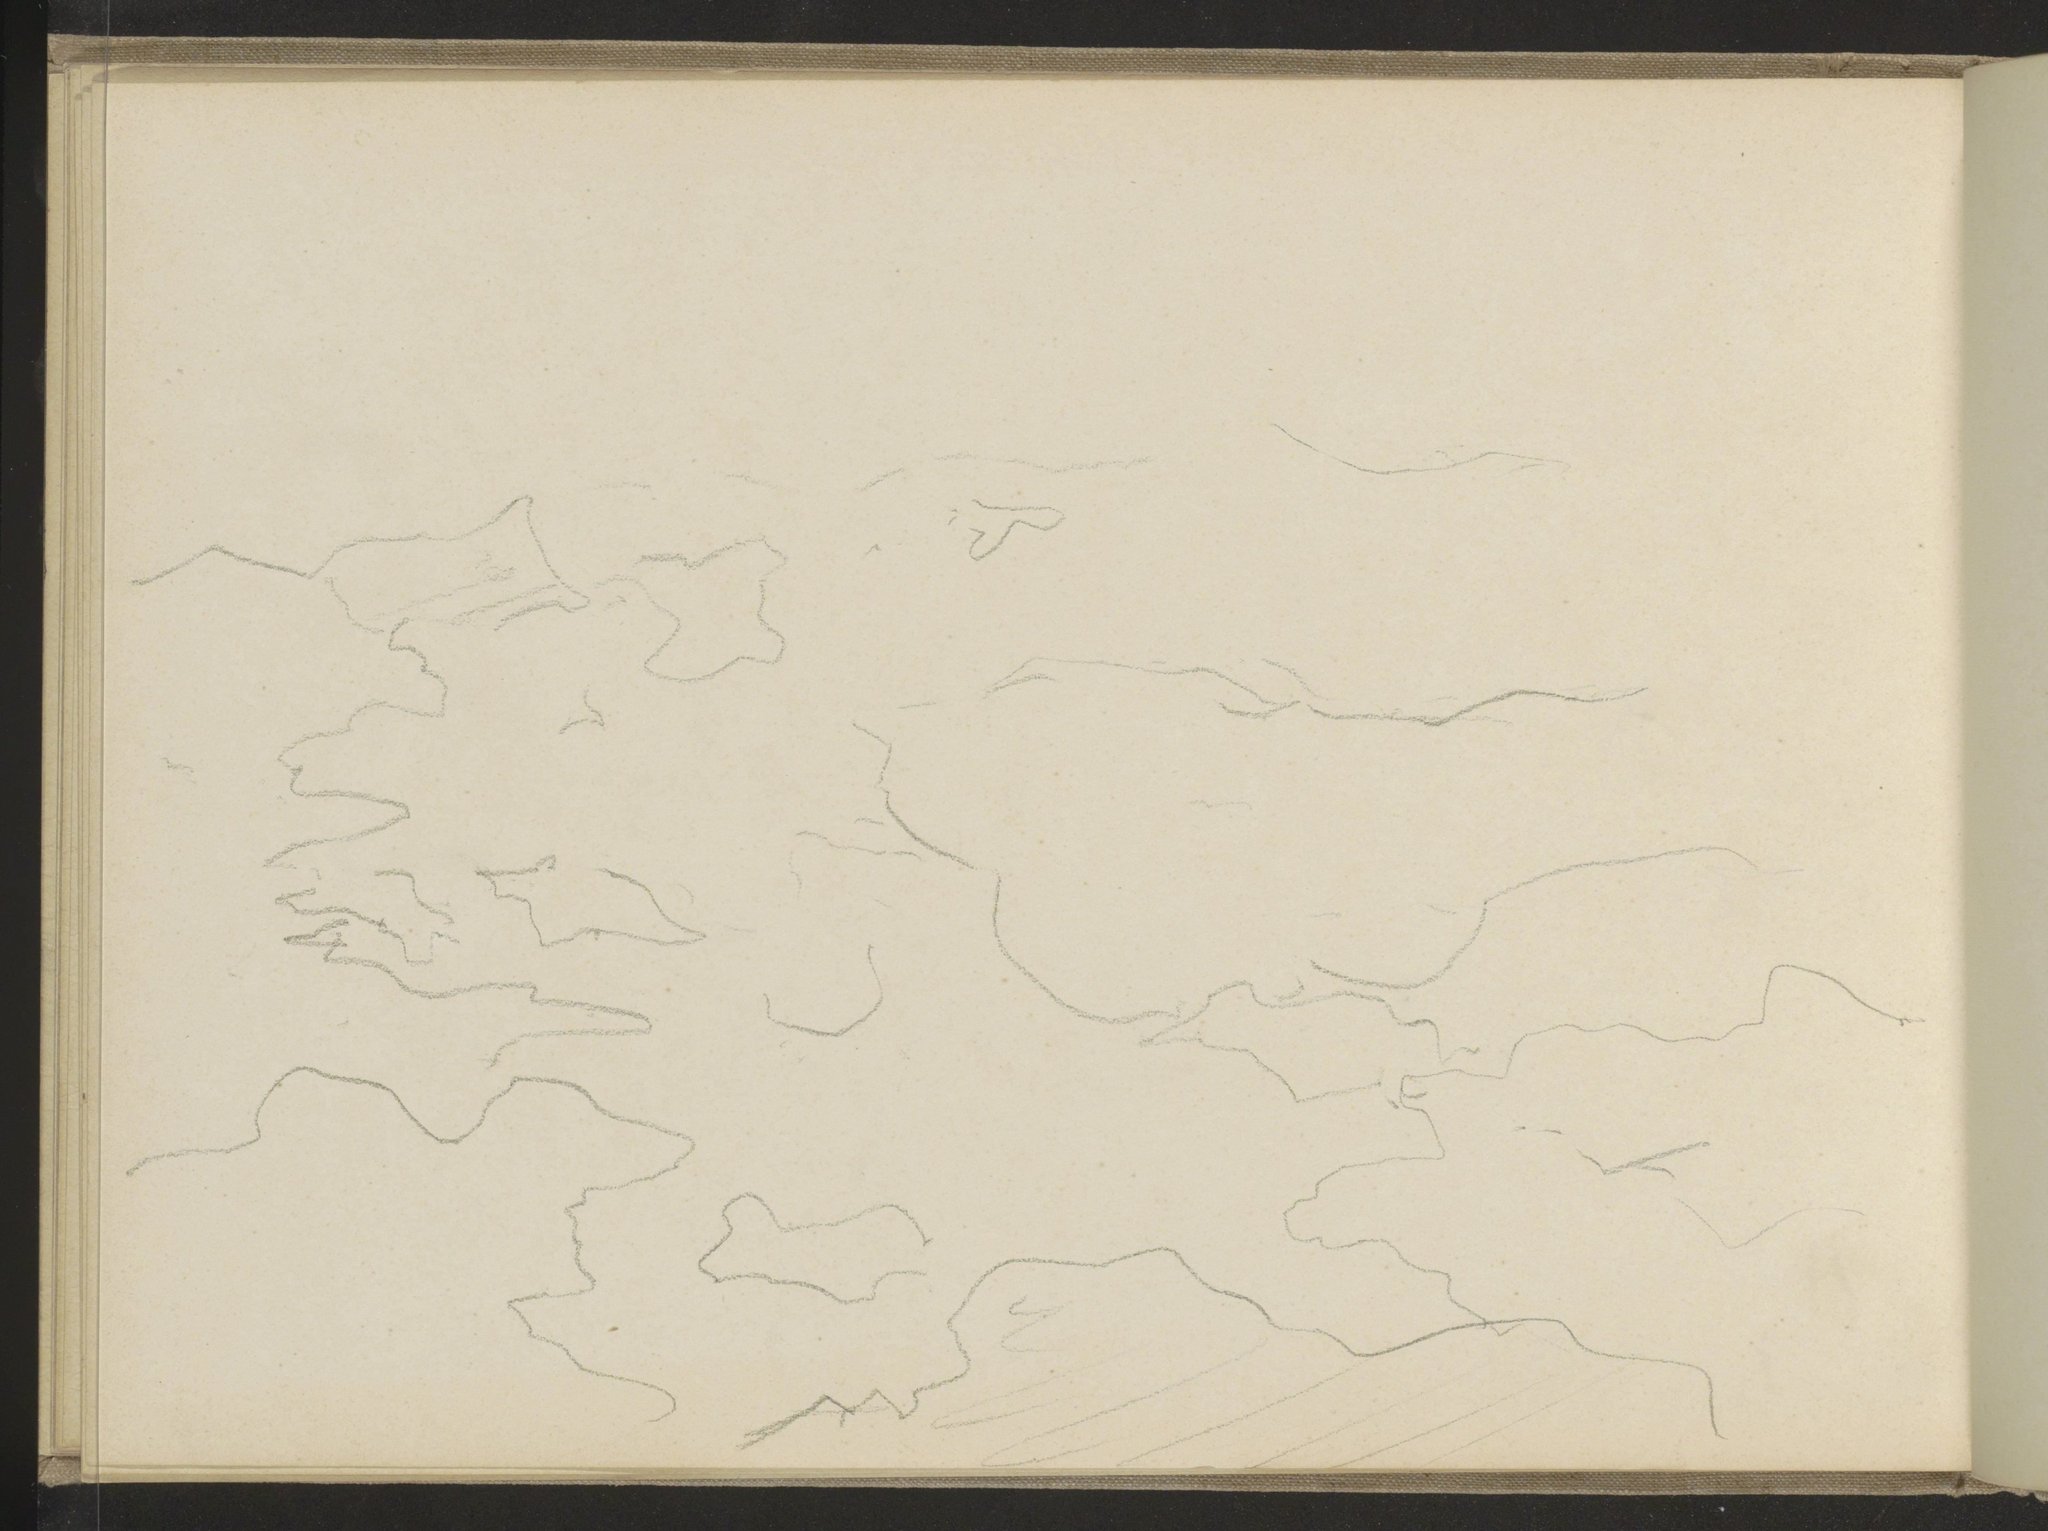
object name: sketchbook leaf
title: Wolken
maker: jozef israëls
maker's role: draughtsman, painter, print maker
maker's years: 1824-1911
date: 1834-1911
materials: paper, pencil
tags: clouds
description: Blad 18 verso uit een schetsboek met 27 bladen.